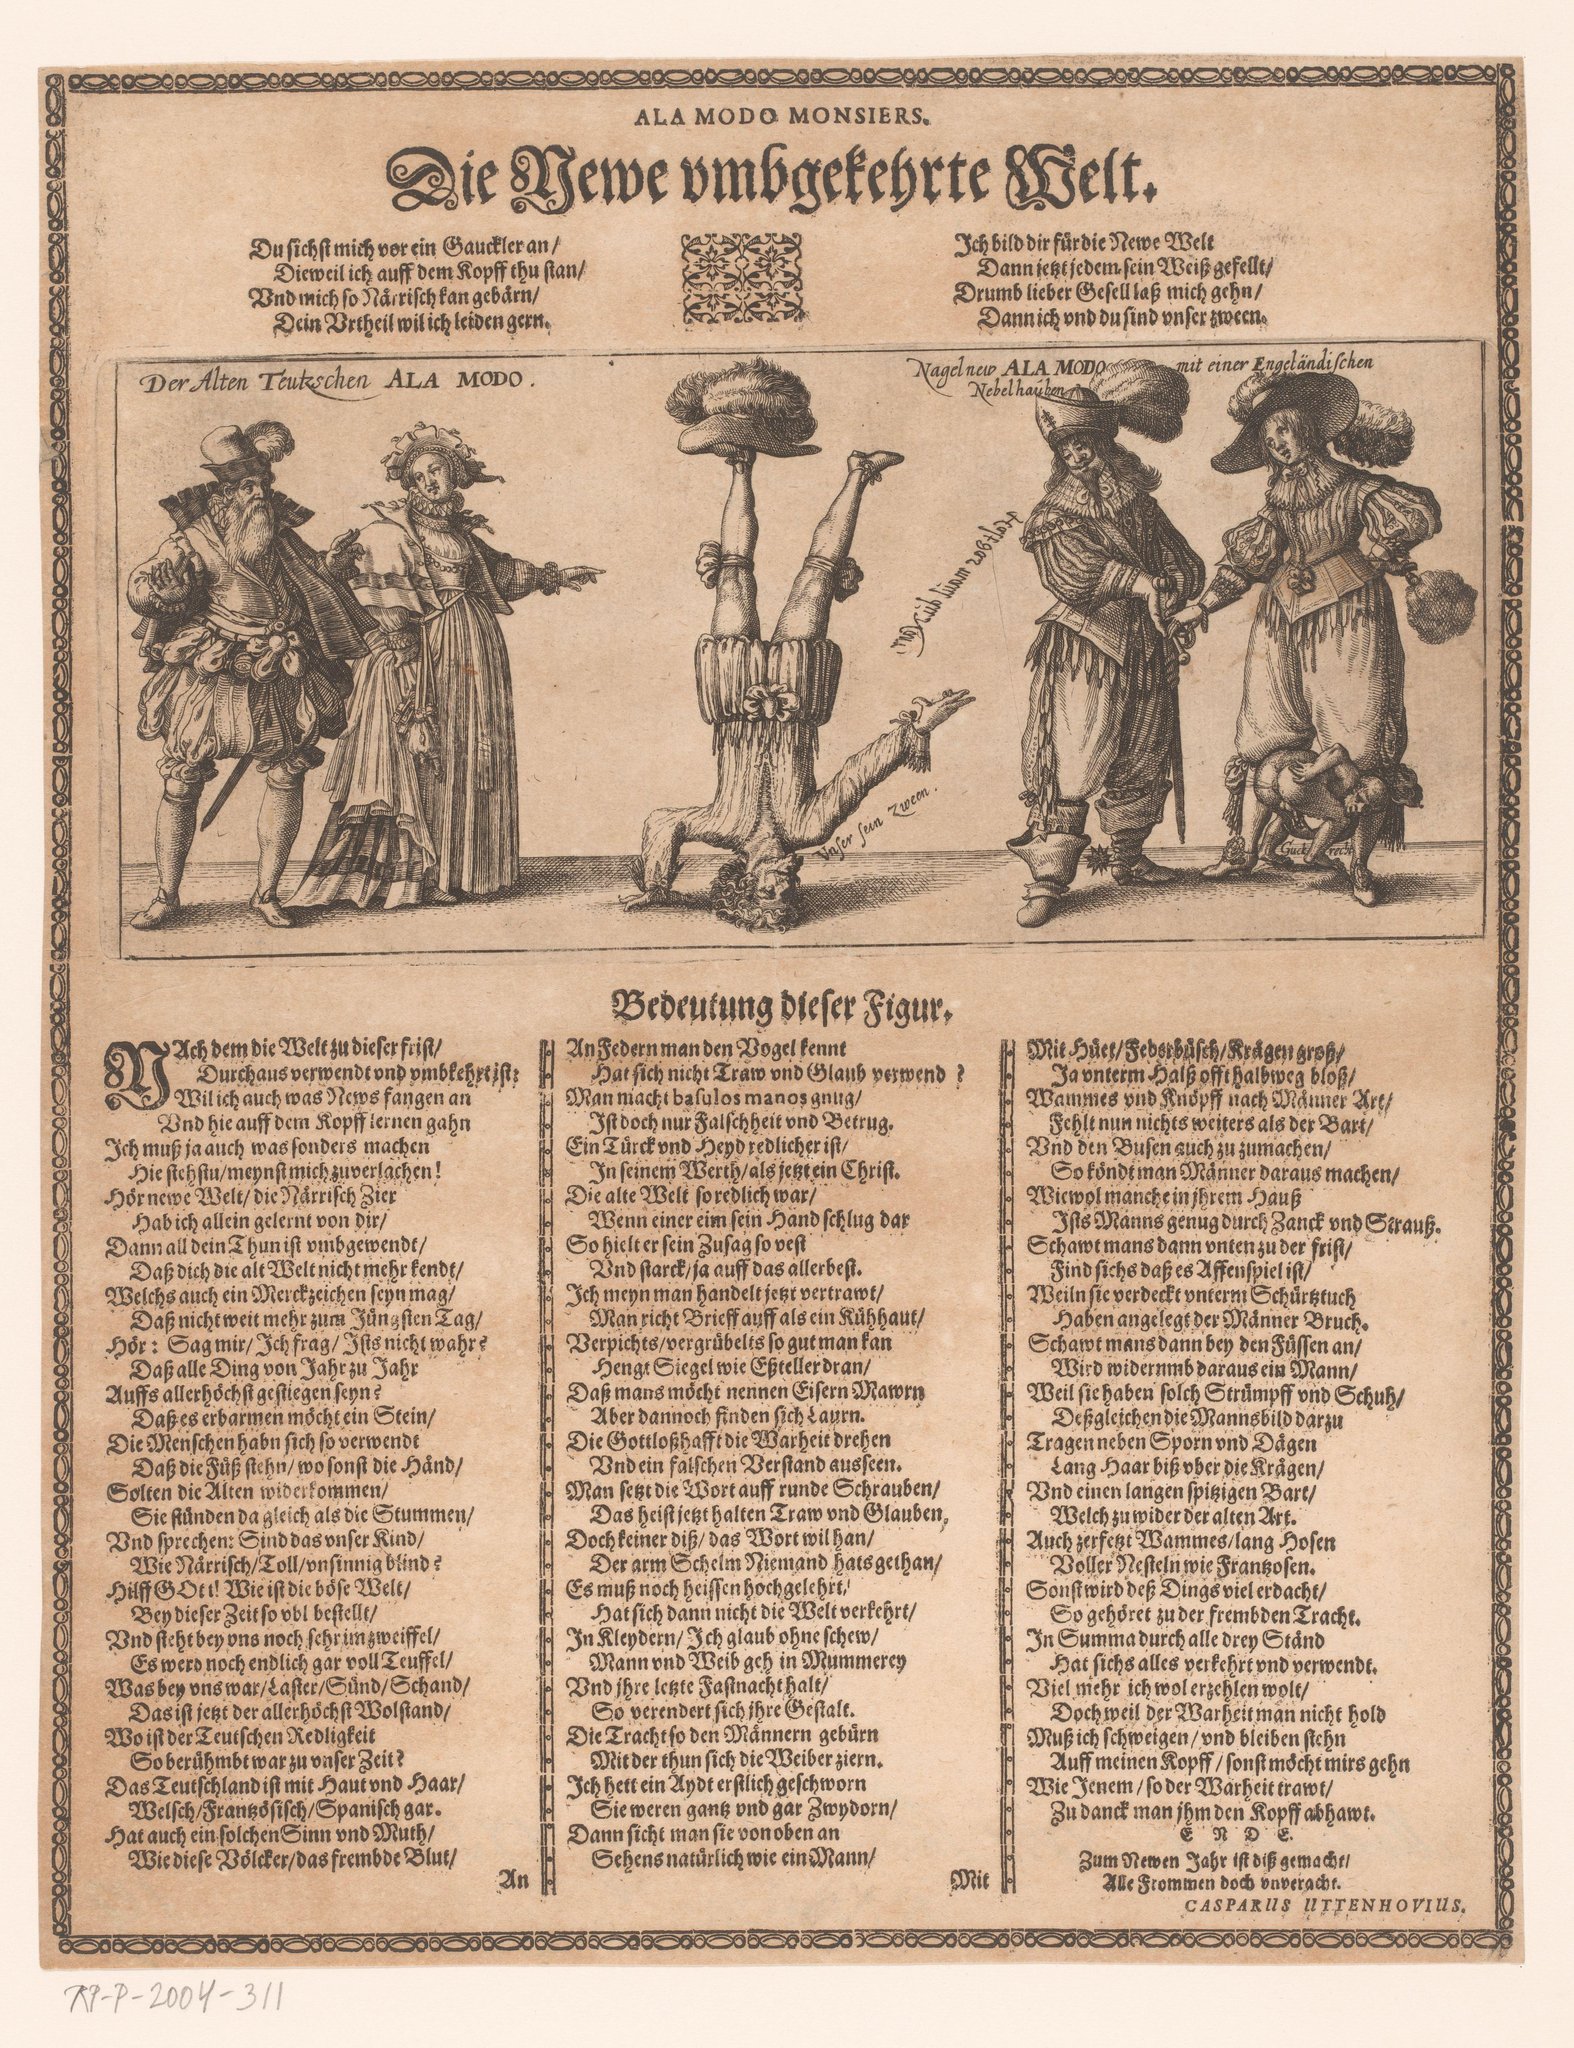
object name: print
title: Nieuwe omgekeerde wereld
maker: Anonymous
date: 1628-1630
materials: paper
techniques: engraving, etching, letterpress printing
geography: germany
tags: fashion plates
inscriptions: collector's mark: Lugt 2228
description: Satire op de jongste Franse mode die ca. 1629 zijn intrede doet in Duitsland. De traditionele Duitse eerbaarheid en Duitse kleding worden vervangen door de Franse mode en het Franse bedrog. In het midden een nar, staand op zijn hoofd en met een fraai hoofddeksel op zijn rechtervoet. Links staat een paar dat is gekleed volgens 'Der Alten Teutschen ALA MODO'. Rechts een man en vrouw gekleed volgens de Engelse mode: 'Nagel new ALA MODO mit einer Engeländischen Nebel hauben'. Onder de afbeelding drie kolommen verklarende Duitse tekst in boekdruk.